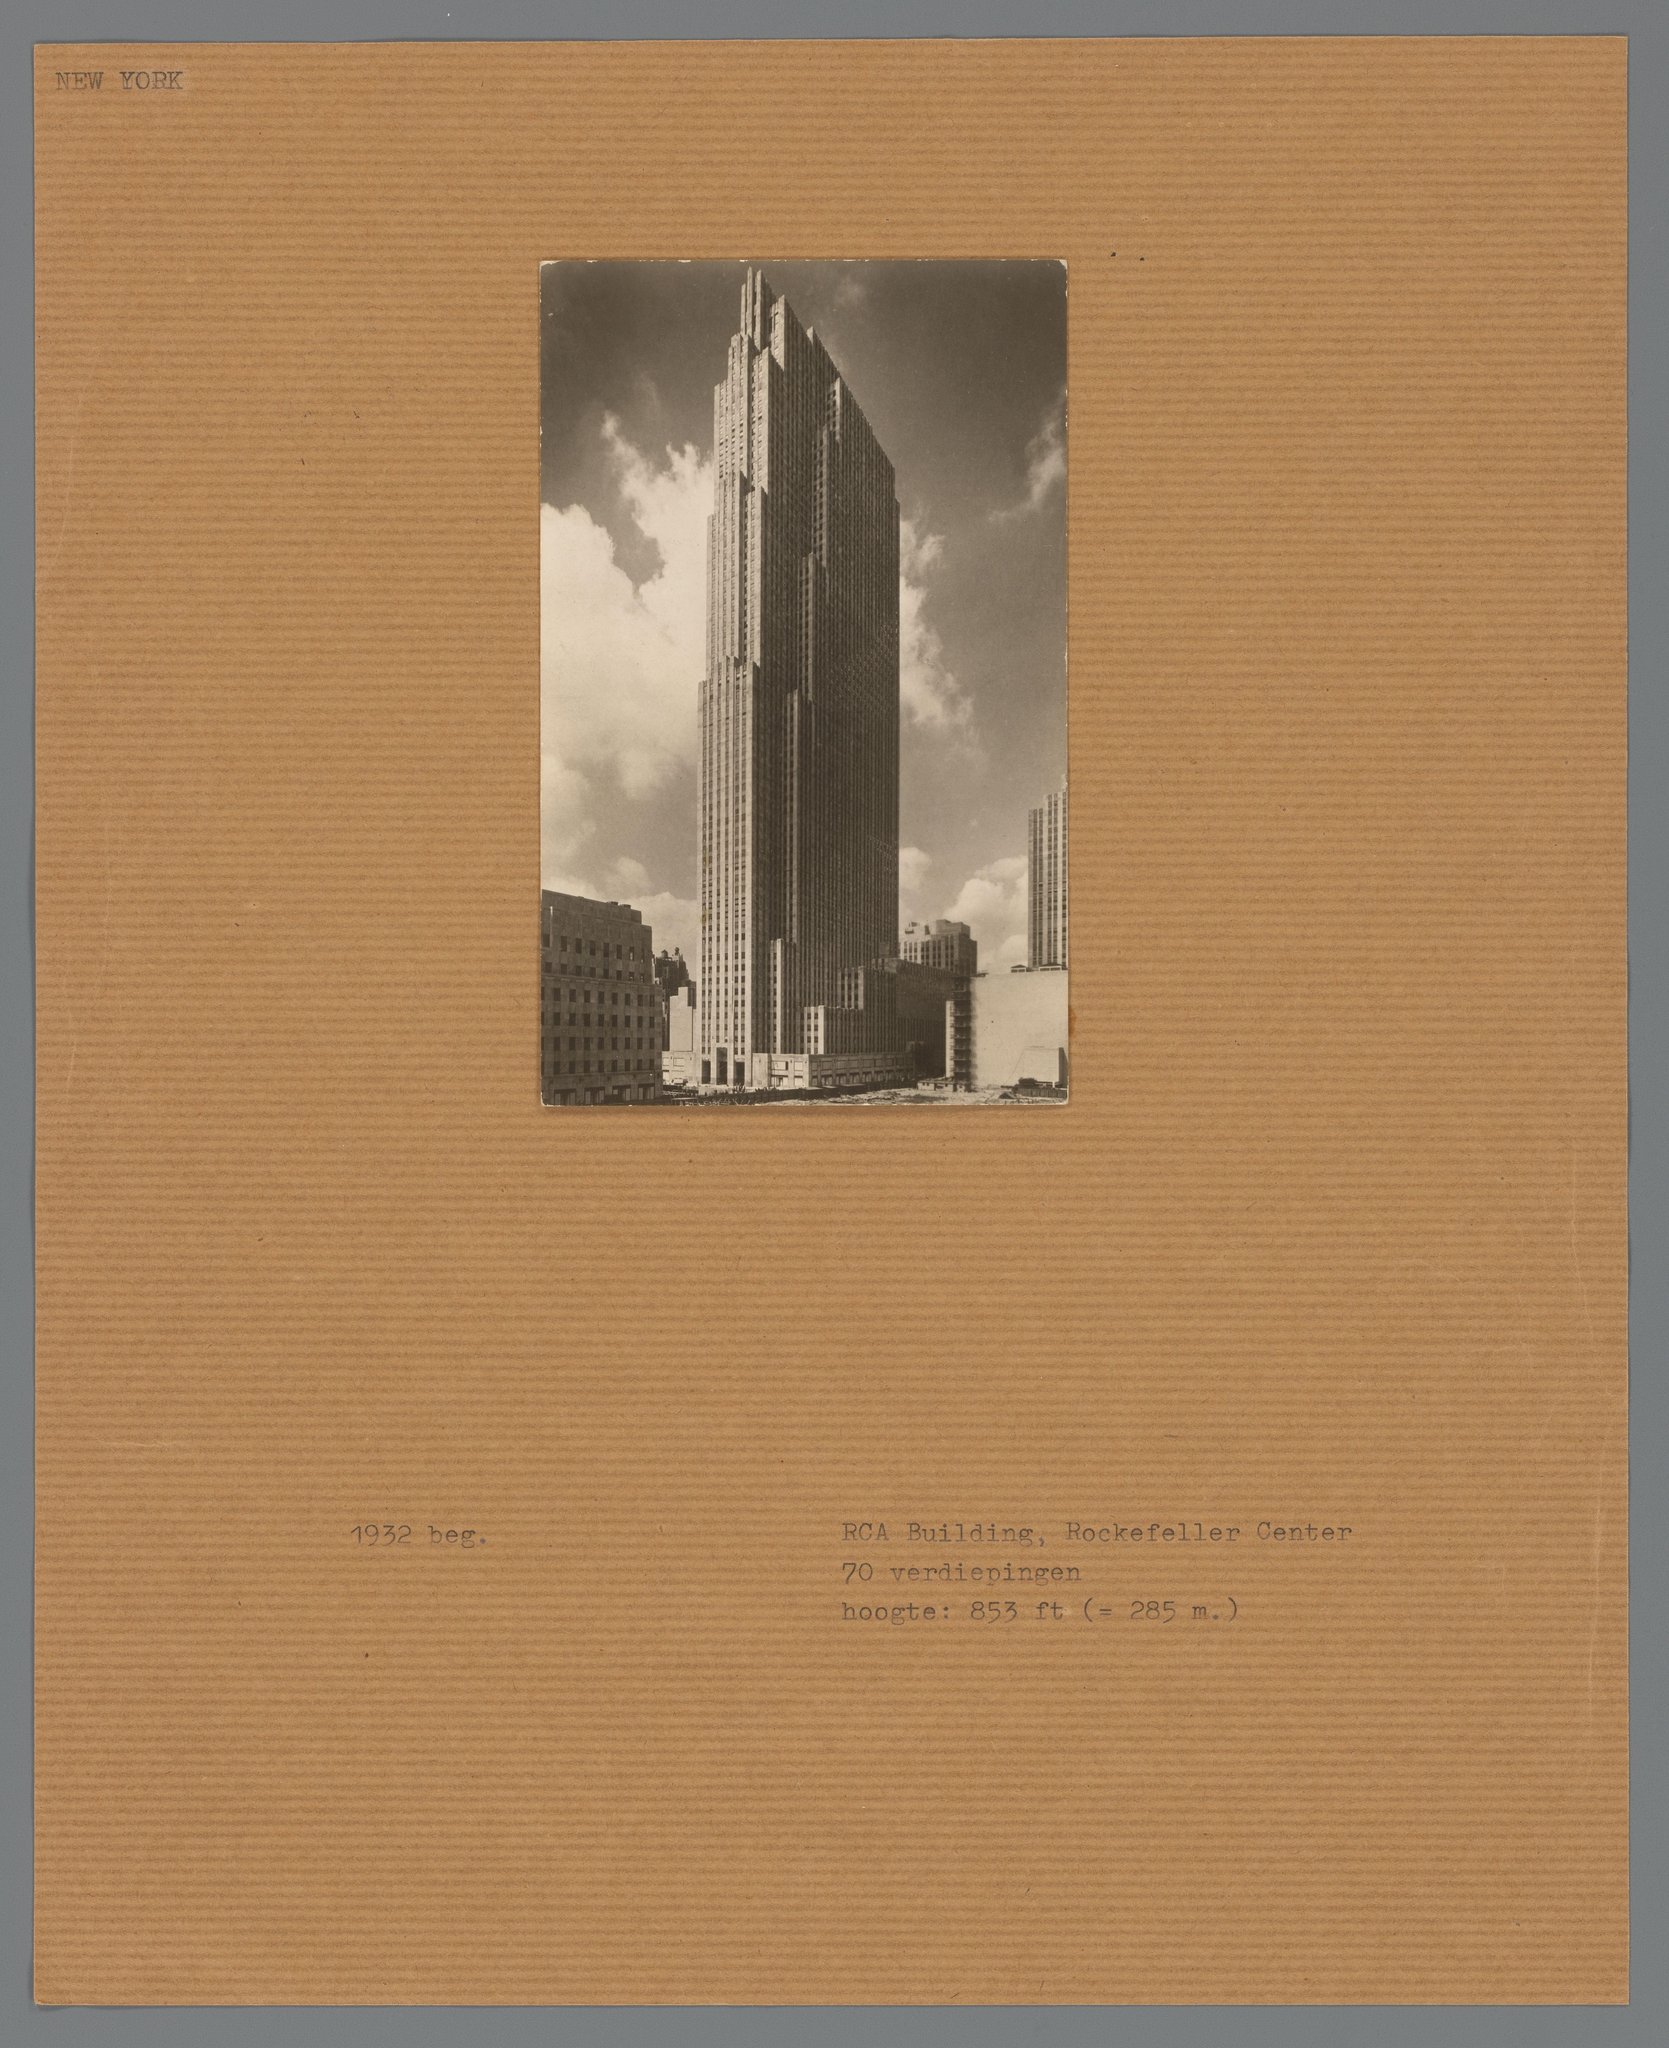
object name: ansichtkaart, prentbriefkaart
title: RCA Building, Rockefeller Center, New York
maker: samuel gottscho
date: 1935-1960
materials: photographic support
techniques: gelatin silver print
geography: new york city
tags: moskou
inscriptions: annotation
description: Een foto van het Rockefeller Center op drager.